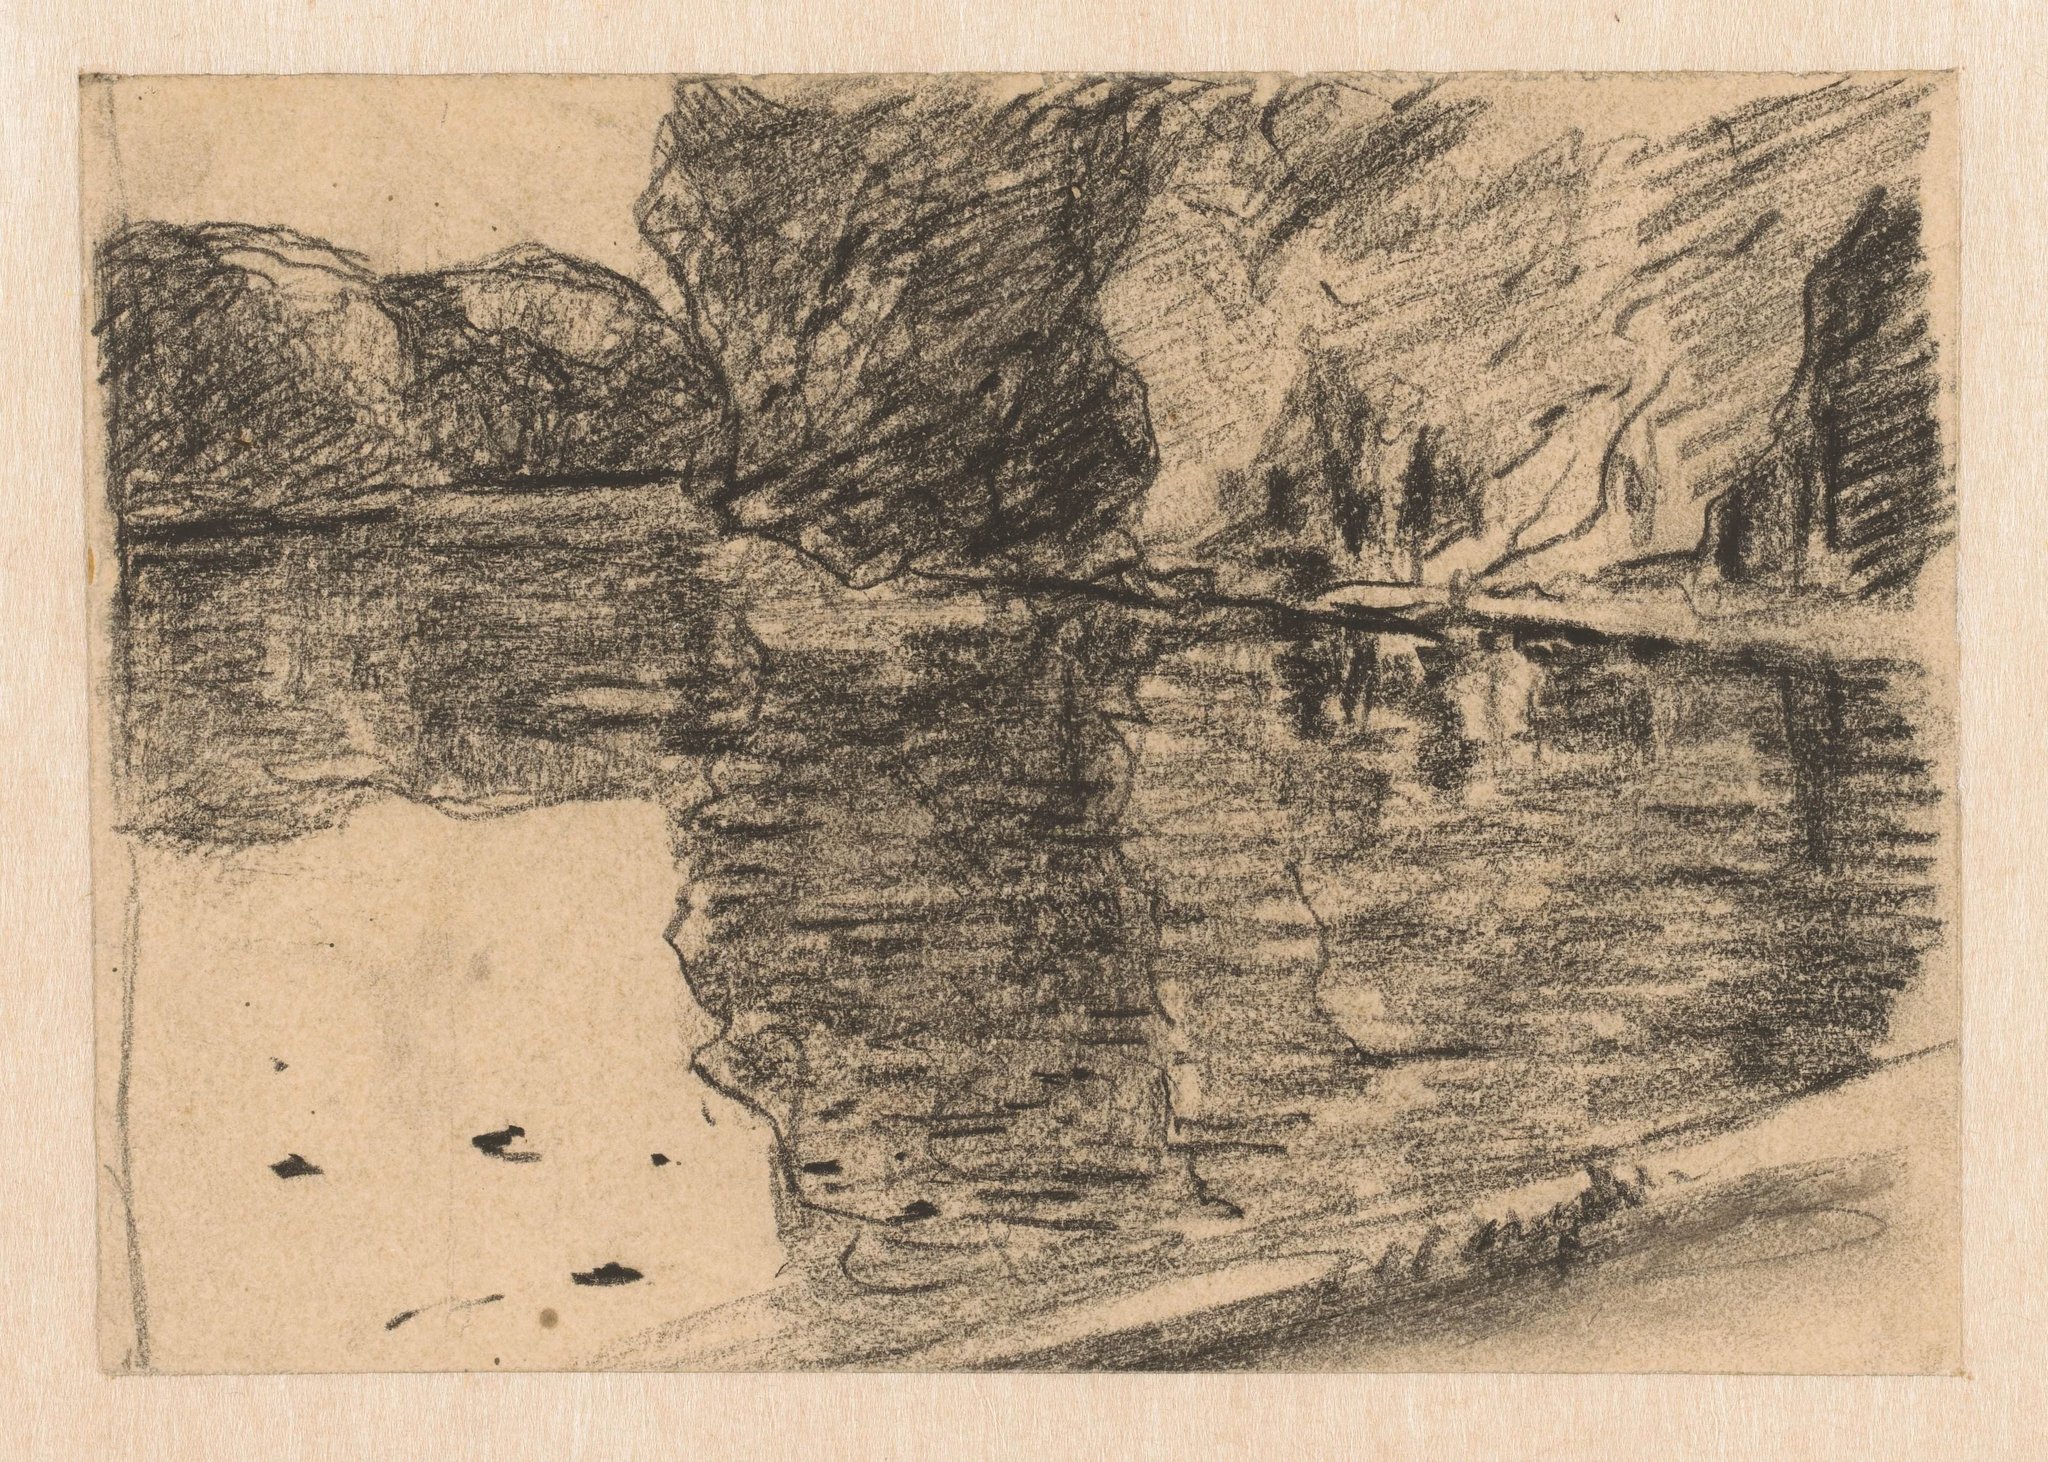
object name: drawing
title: Gezicht op een rivier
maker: carel nicolaas storm van s-gravesande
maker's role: draughtsman, print maker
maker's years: 1841-1924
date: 1851-1924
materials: chalk, paper